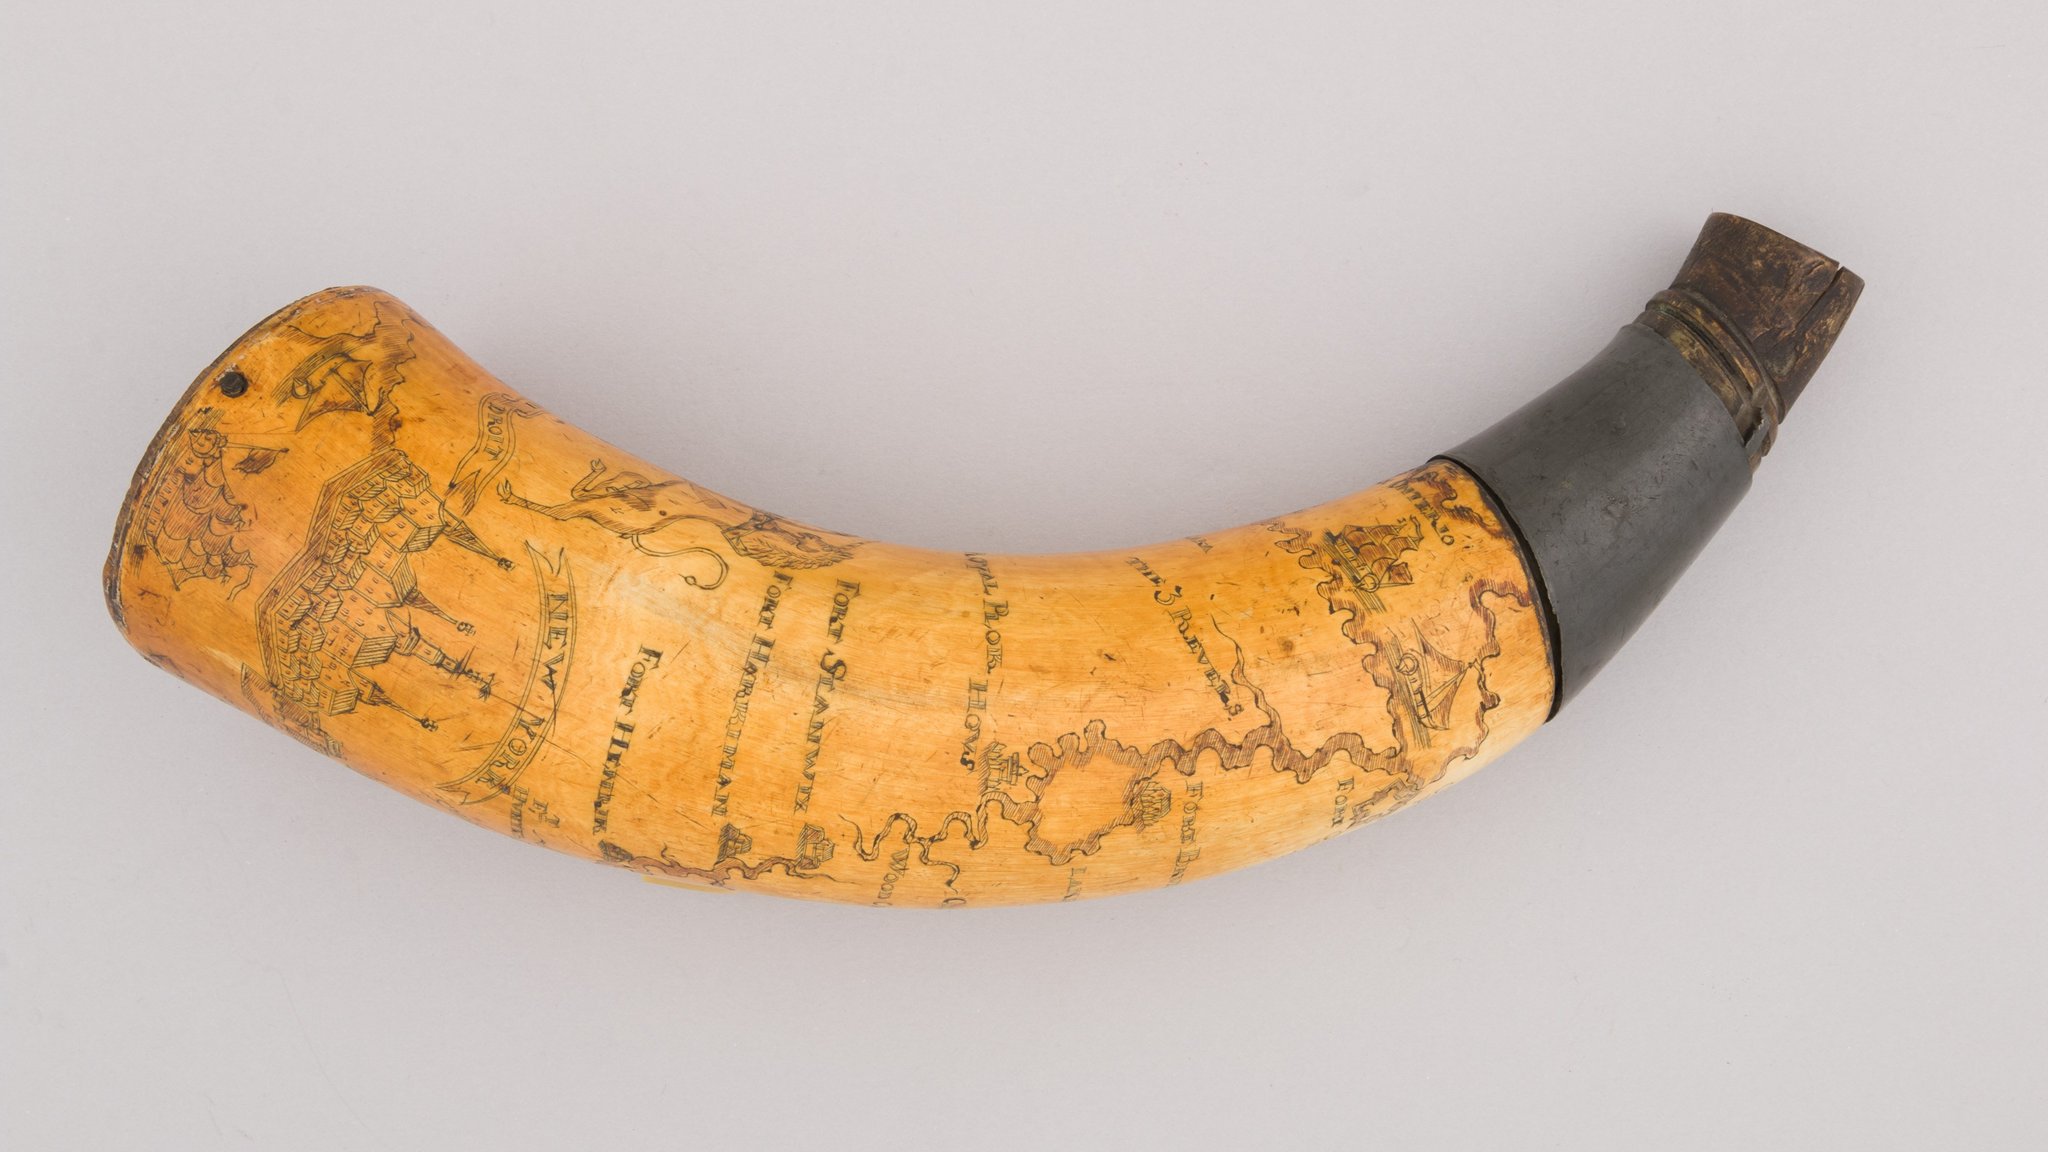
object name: powder horn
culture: american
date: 1701-1800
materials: horn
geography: united states